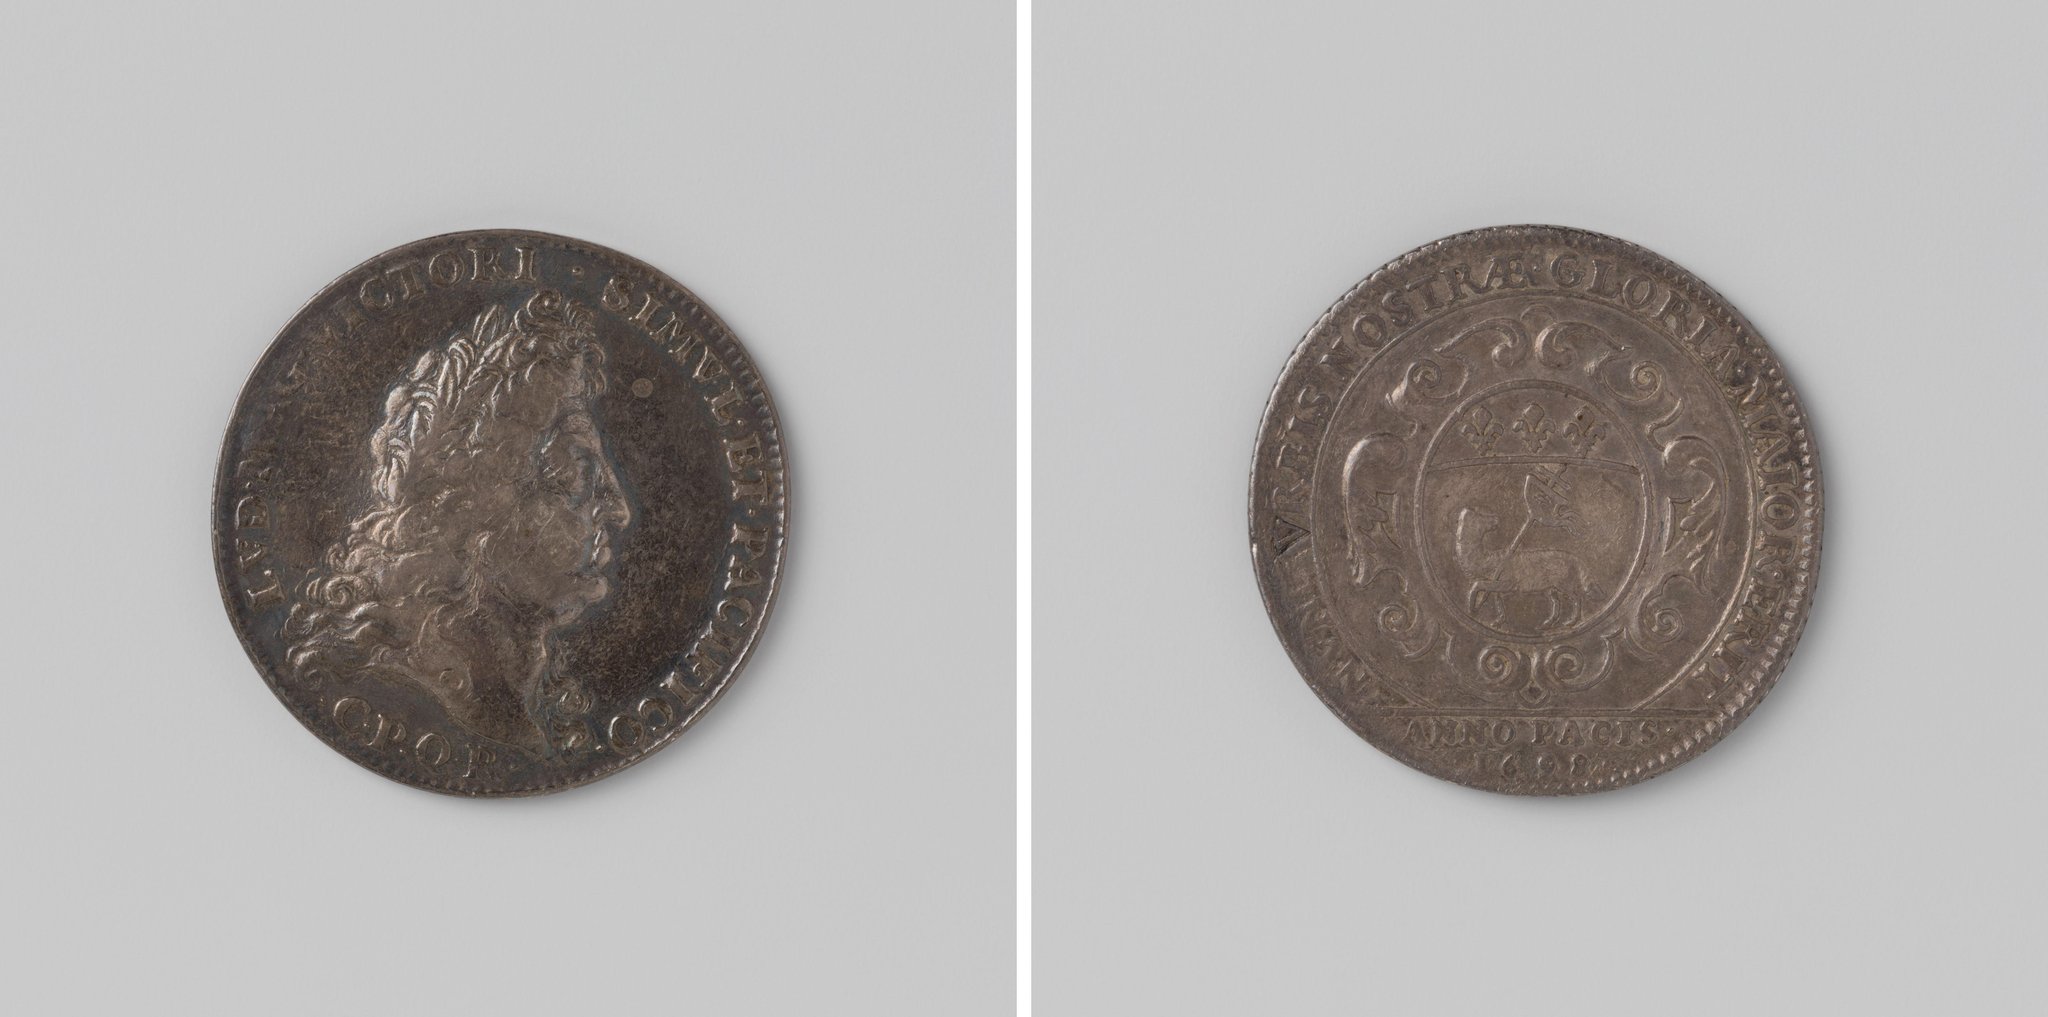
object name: jeton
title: Vrede van Rijswijk, ter ere van Lodewijk XIV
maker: Anonymous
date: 1698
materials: silver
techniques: striking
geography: france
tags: lodewijk xiv (koning van frankrijk)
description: Zilveren penning. Voorzijde: borststuk man met lauwerkrans binnen omschrift. Keerzijde: wapenschild binnen omschrift; afsnede: opschrift